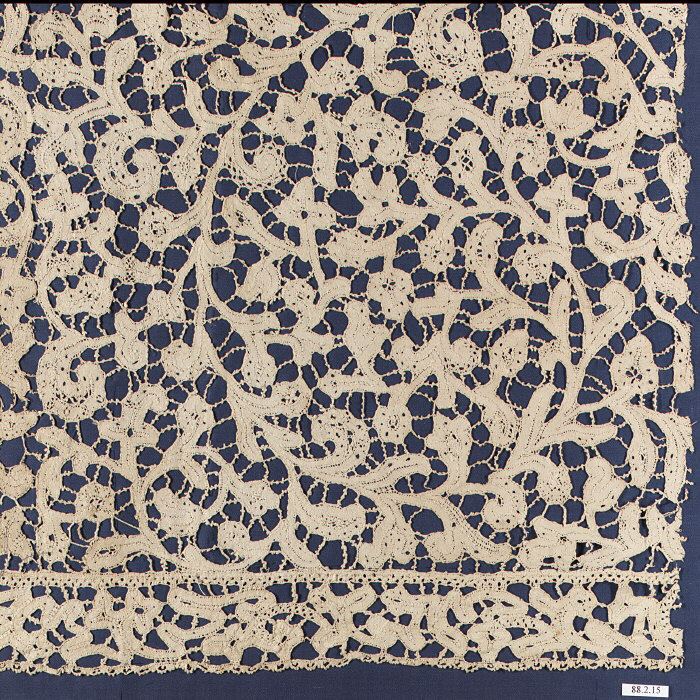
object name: piece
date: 1601-1700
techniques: lace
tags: flowers,leaves